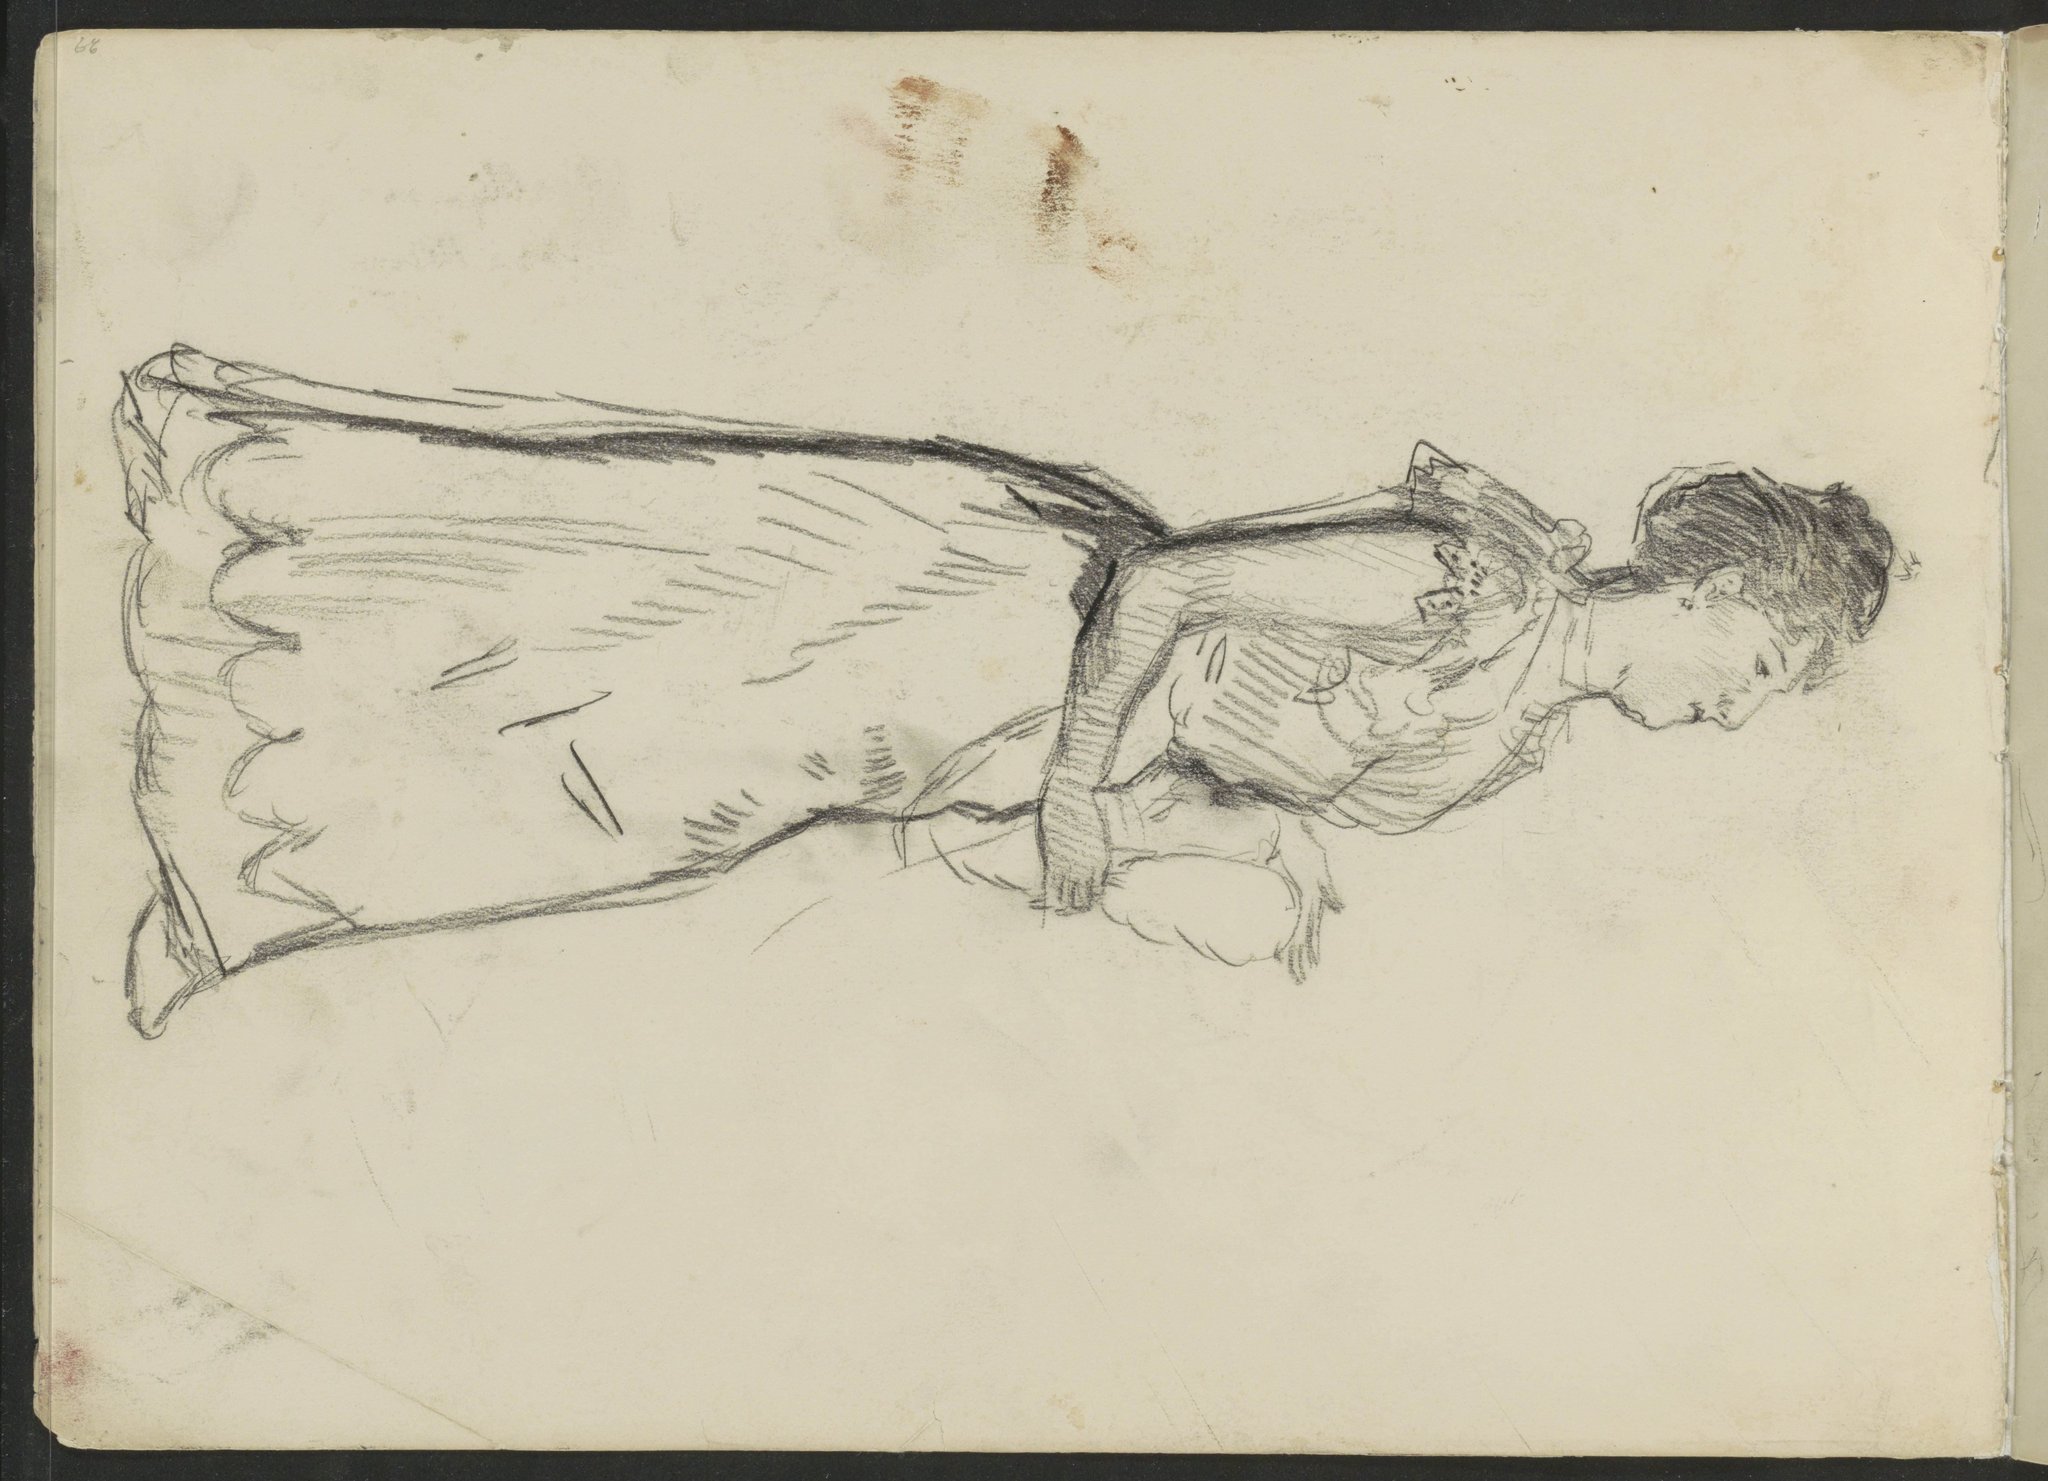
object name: sketchbook leaf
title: Staande vrouw met verenwaaier, in profiel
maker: isaac israels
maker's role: draughtsman, painter, print maker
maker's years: 1865-1934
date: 1886-1934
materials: chalk, paper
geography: amsterdam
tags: fan, adult woman (+ standing)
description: Blad 2 verso uit schetsboek LXVII met 11 bladen.